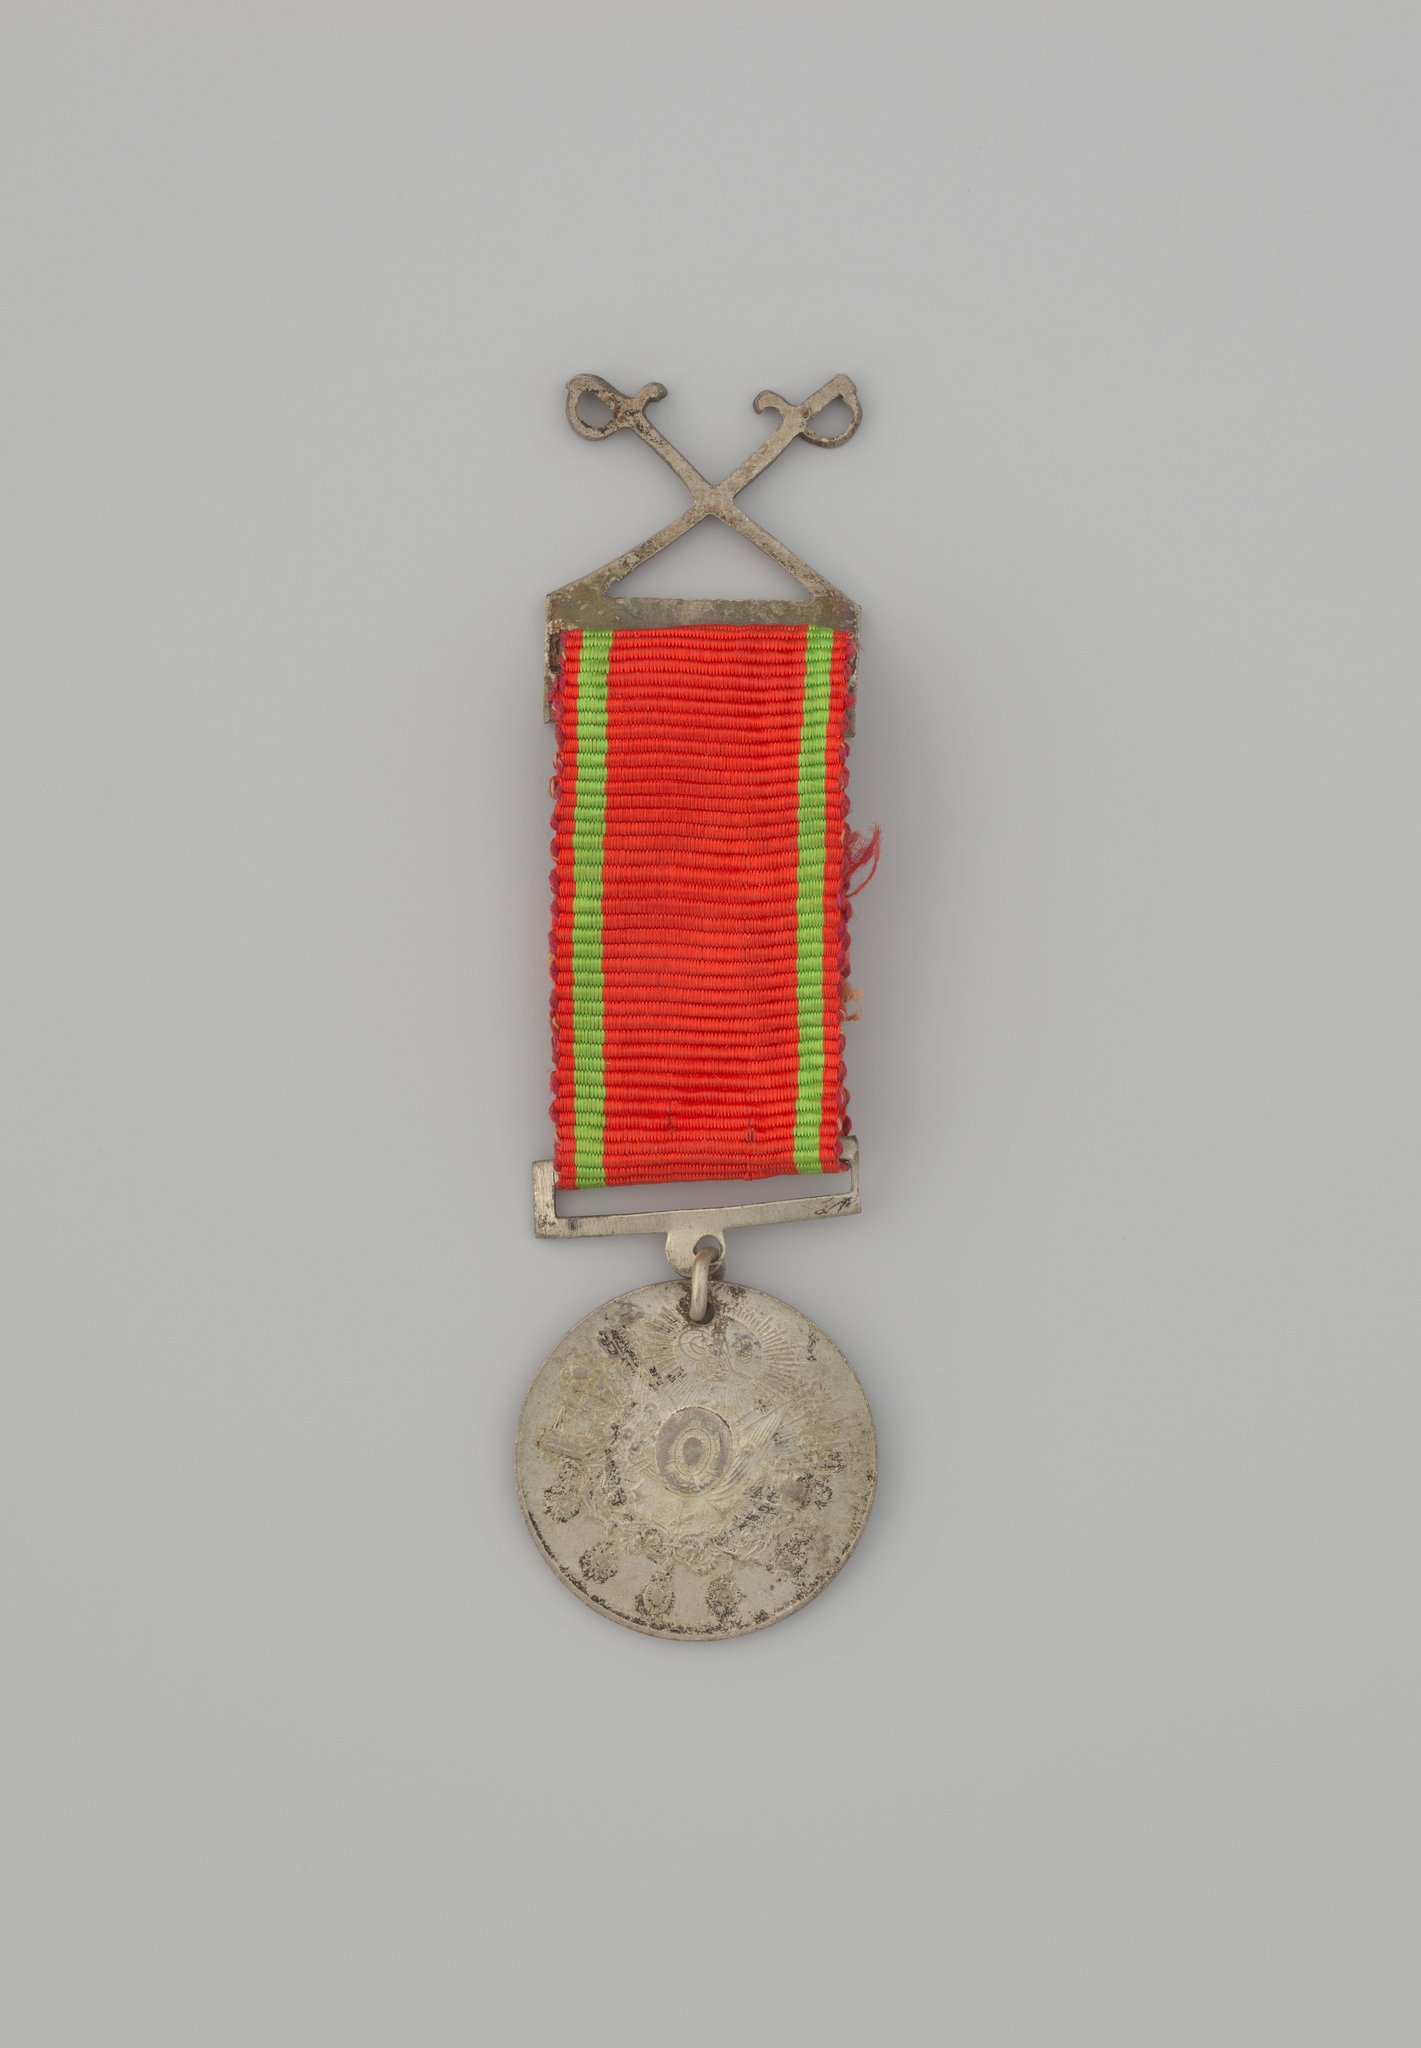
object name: onderscheidingsteken, onderscheiding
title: Turkse Liakat medaille aan lint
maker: Anonymous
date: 1915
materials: metal, silk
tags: eugen wachenheimer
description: Dit object is onderdeel van de nalatenschap van Isabel Elon-Wachenheimer (1928-2010). Tot haar overlijden behoorde het samen met de andere objecten uit de nalatenschap tot haar privédomein van Isabel Wachenheimer. In die particuliere context zijn deze objecten tezamen en individueel aandenkens - aan de jeugd, ouders en familie van Isabel Wachenheimer vóór en tijdens de Shoah en aan haar leven na de Tweede Wereldoorlog. Isabel Wachenheimer, die van juni 1943 tot mei 1945 gevangen zat in Kamp Westerbork, Theresienstadt, Auschwitz, Lenzing a/d Oberdonau (een buitenkamp van Mauthausen), overleefde de Shoah. Haar ouders – Eugène Wachenheimer en Else Wachenheimer-Moos - werden op 14 oktober 1944 in Auschwitz-Birkenau vermoord.